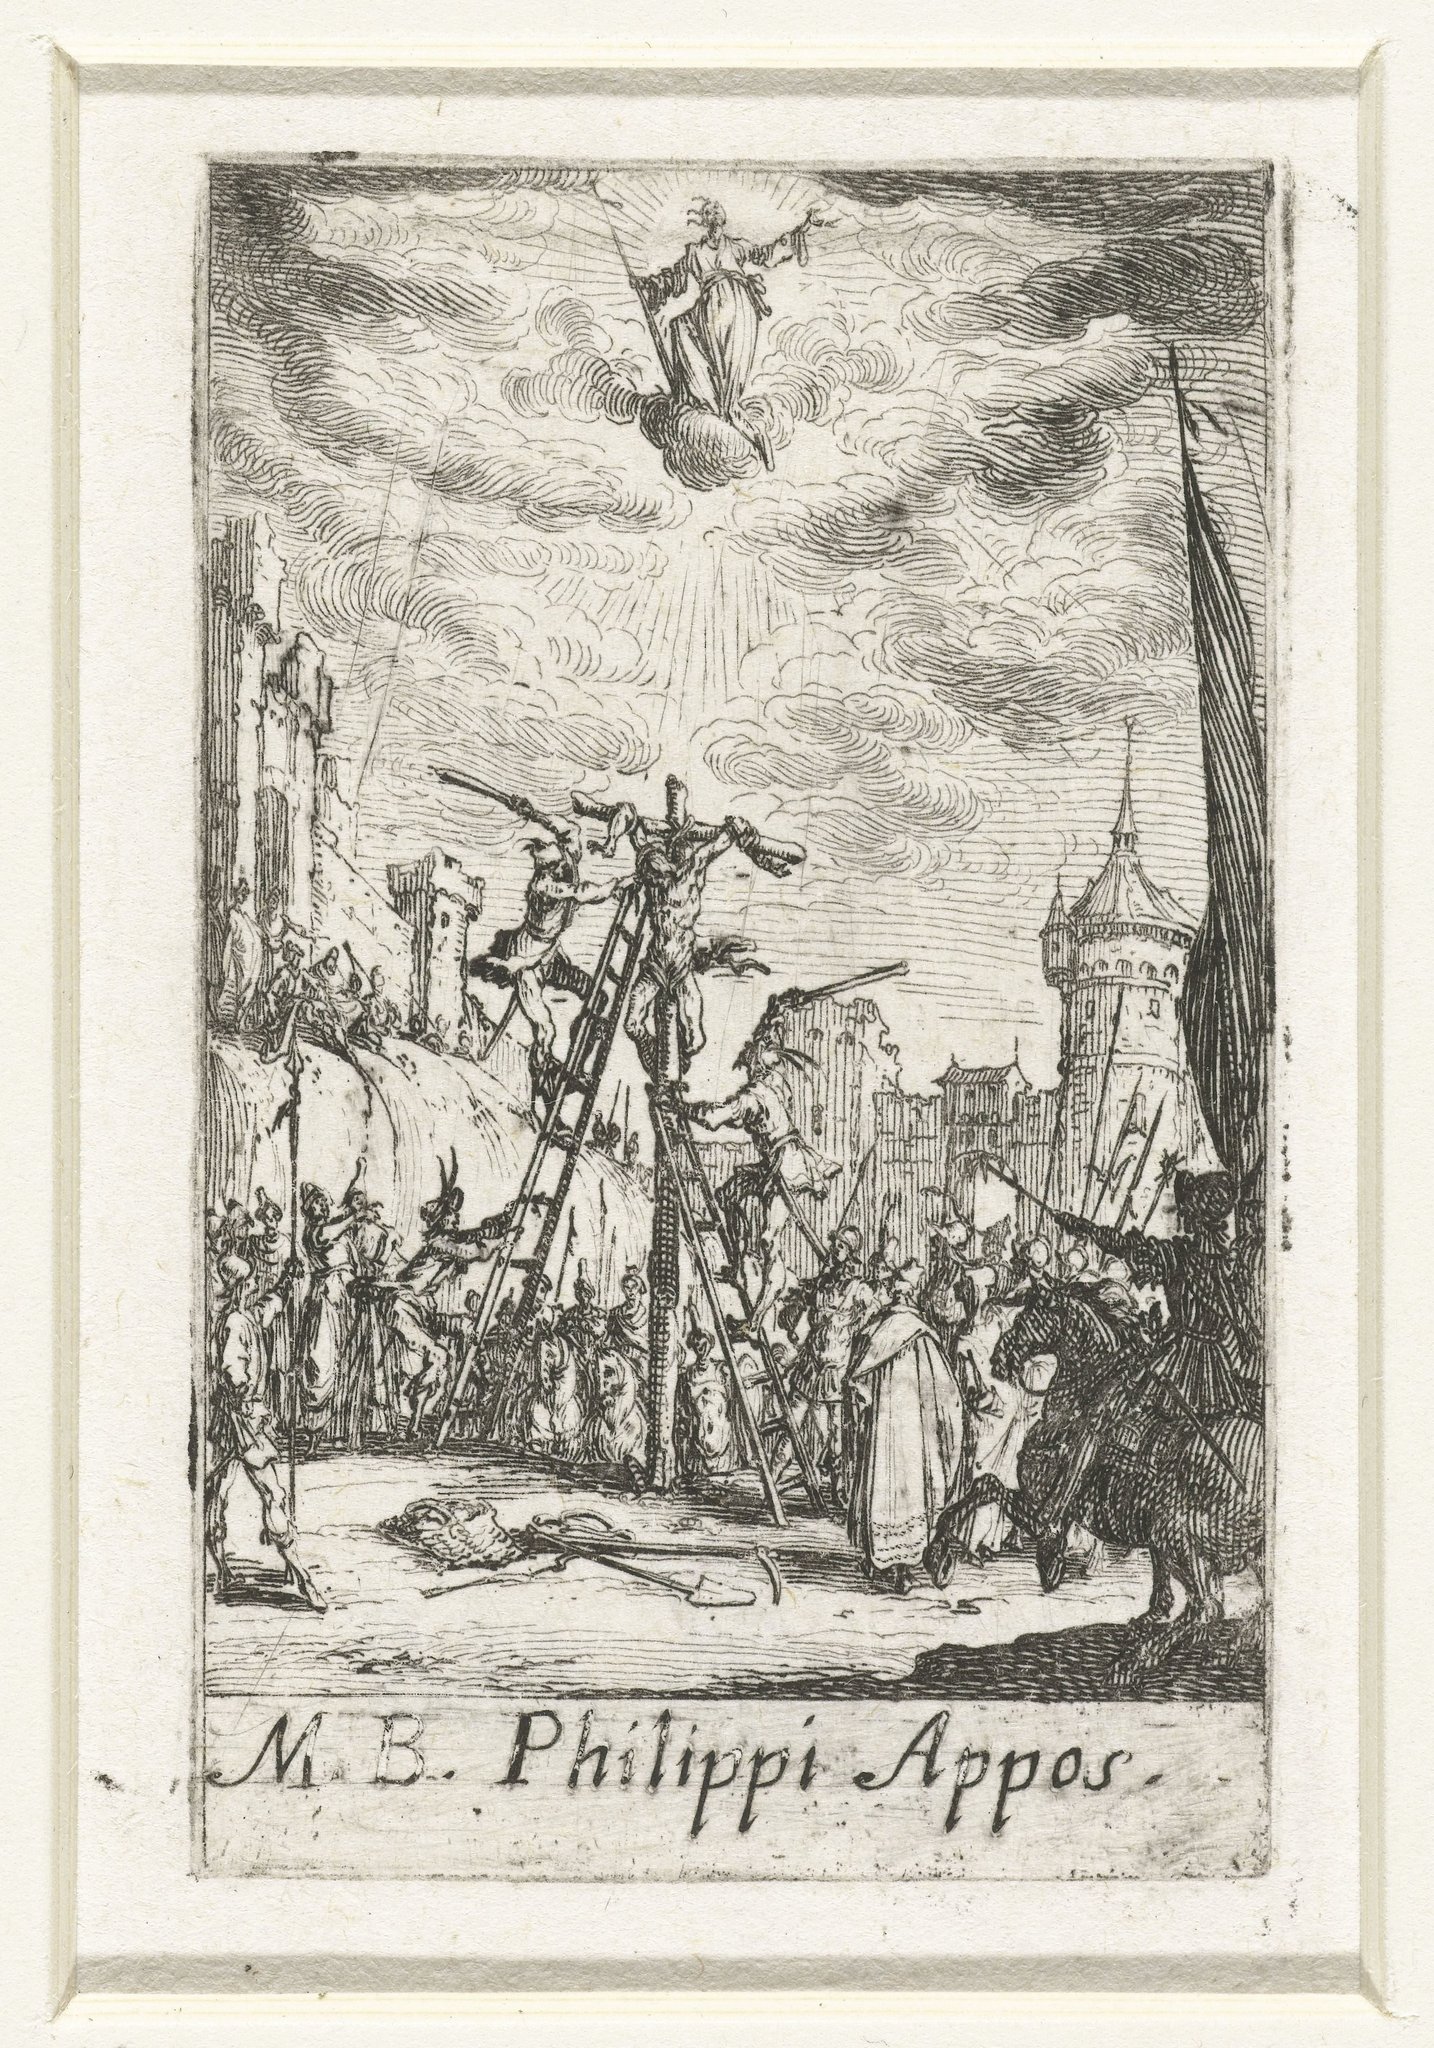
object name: print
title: De kleine apostelen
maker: jacques callot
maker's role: draughtsman, print maker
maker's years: 1592-1635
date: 1632-1634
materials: paper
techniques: etching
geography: nancy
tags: philip is crucified (sometimes upside down), the apostle philip; possible attributes: book, cross, dish with snake, lance, scroll, stone, sword - martyrdom, suffering, misfortune, death of male saint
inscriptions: collector's mark: Lugt 240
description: Filippus wordt gekruisigd in het bijzijn van een groep toeschouwers. Boven deze scène is Filippus nogmaals afgebeeld, op een wolk in de hemel, een kruisstaf in de hand. Onder de voorstelling een onderschrift in Latijn. Deze prent is onderdeel van een reeks van 16 prenten, bestaande uit een titelblad en 15 voorstellingen van de martelingen die de apostelen hebben ondergaan.